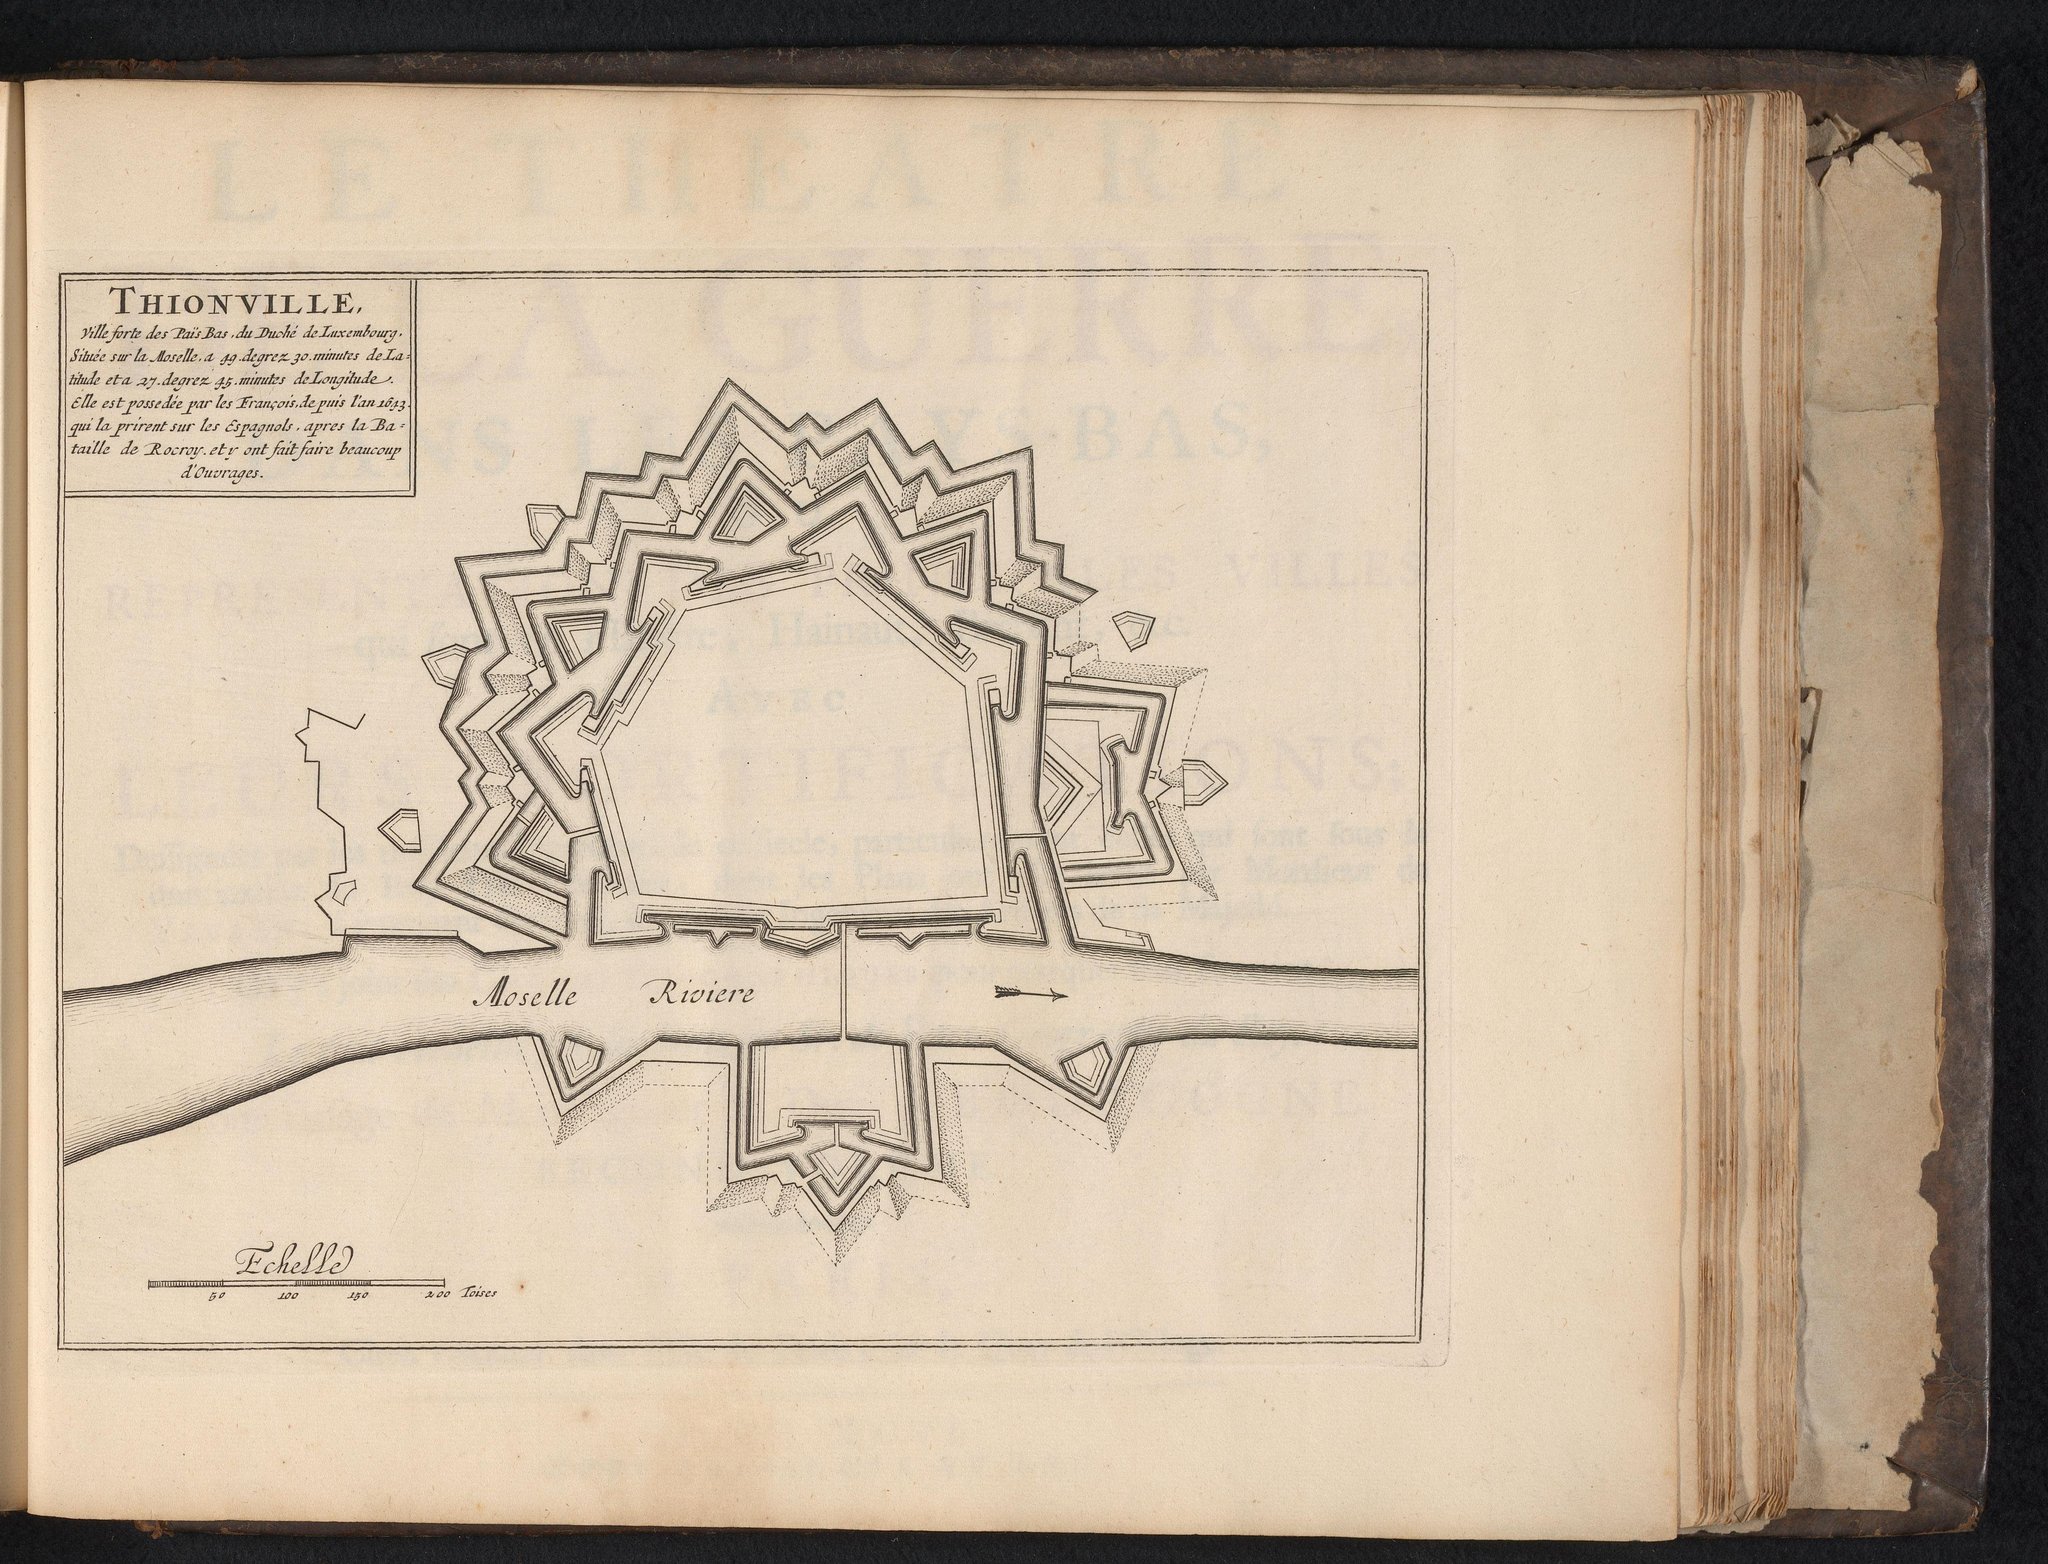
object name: map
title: Plattegrond van Thionville, ca. 1693-1696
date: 1693-1696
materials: paper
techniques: etching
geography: france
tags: fortress, maps of cities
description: Plattegrond van de versterkingen om de Luxemburgse stad Thionville, tegenwoordig in Frankrijk. Onderdeel van het eerste van twee delen van het prentwerk: Le Theatre de la Guerre, dans les Pays-Bas, waarvan het titelblad uitgegeven is in 1696. Het prentwerk bestaat in totaal (beide delen) uit 52 platen met plannen (afkomstig van Sébastien Le Prestre, Seigneur de Vauban) van vermaarde sterke steden en vestingen in de Negenjarige Oorlog in de Nederlanden. Identiek aan de plaat die voorkomt in: Les forces de l'Europe, uitgegeven tussen 1693-1697. Titel en opschriften in het Frans.